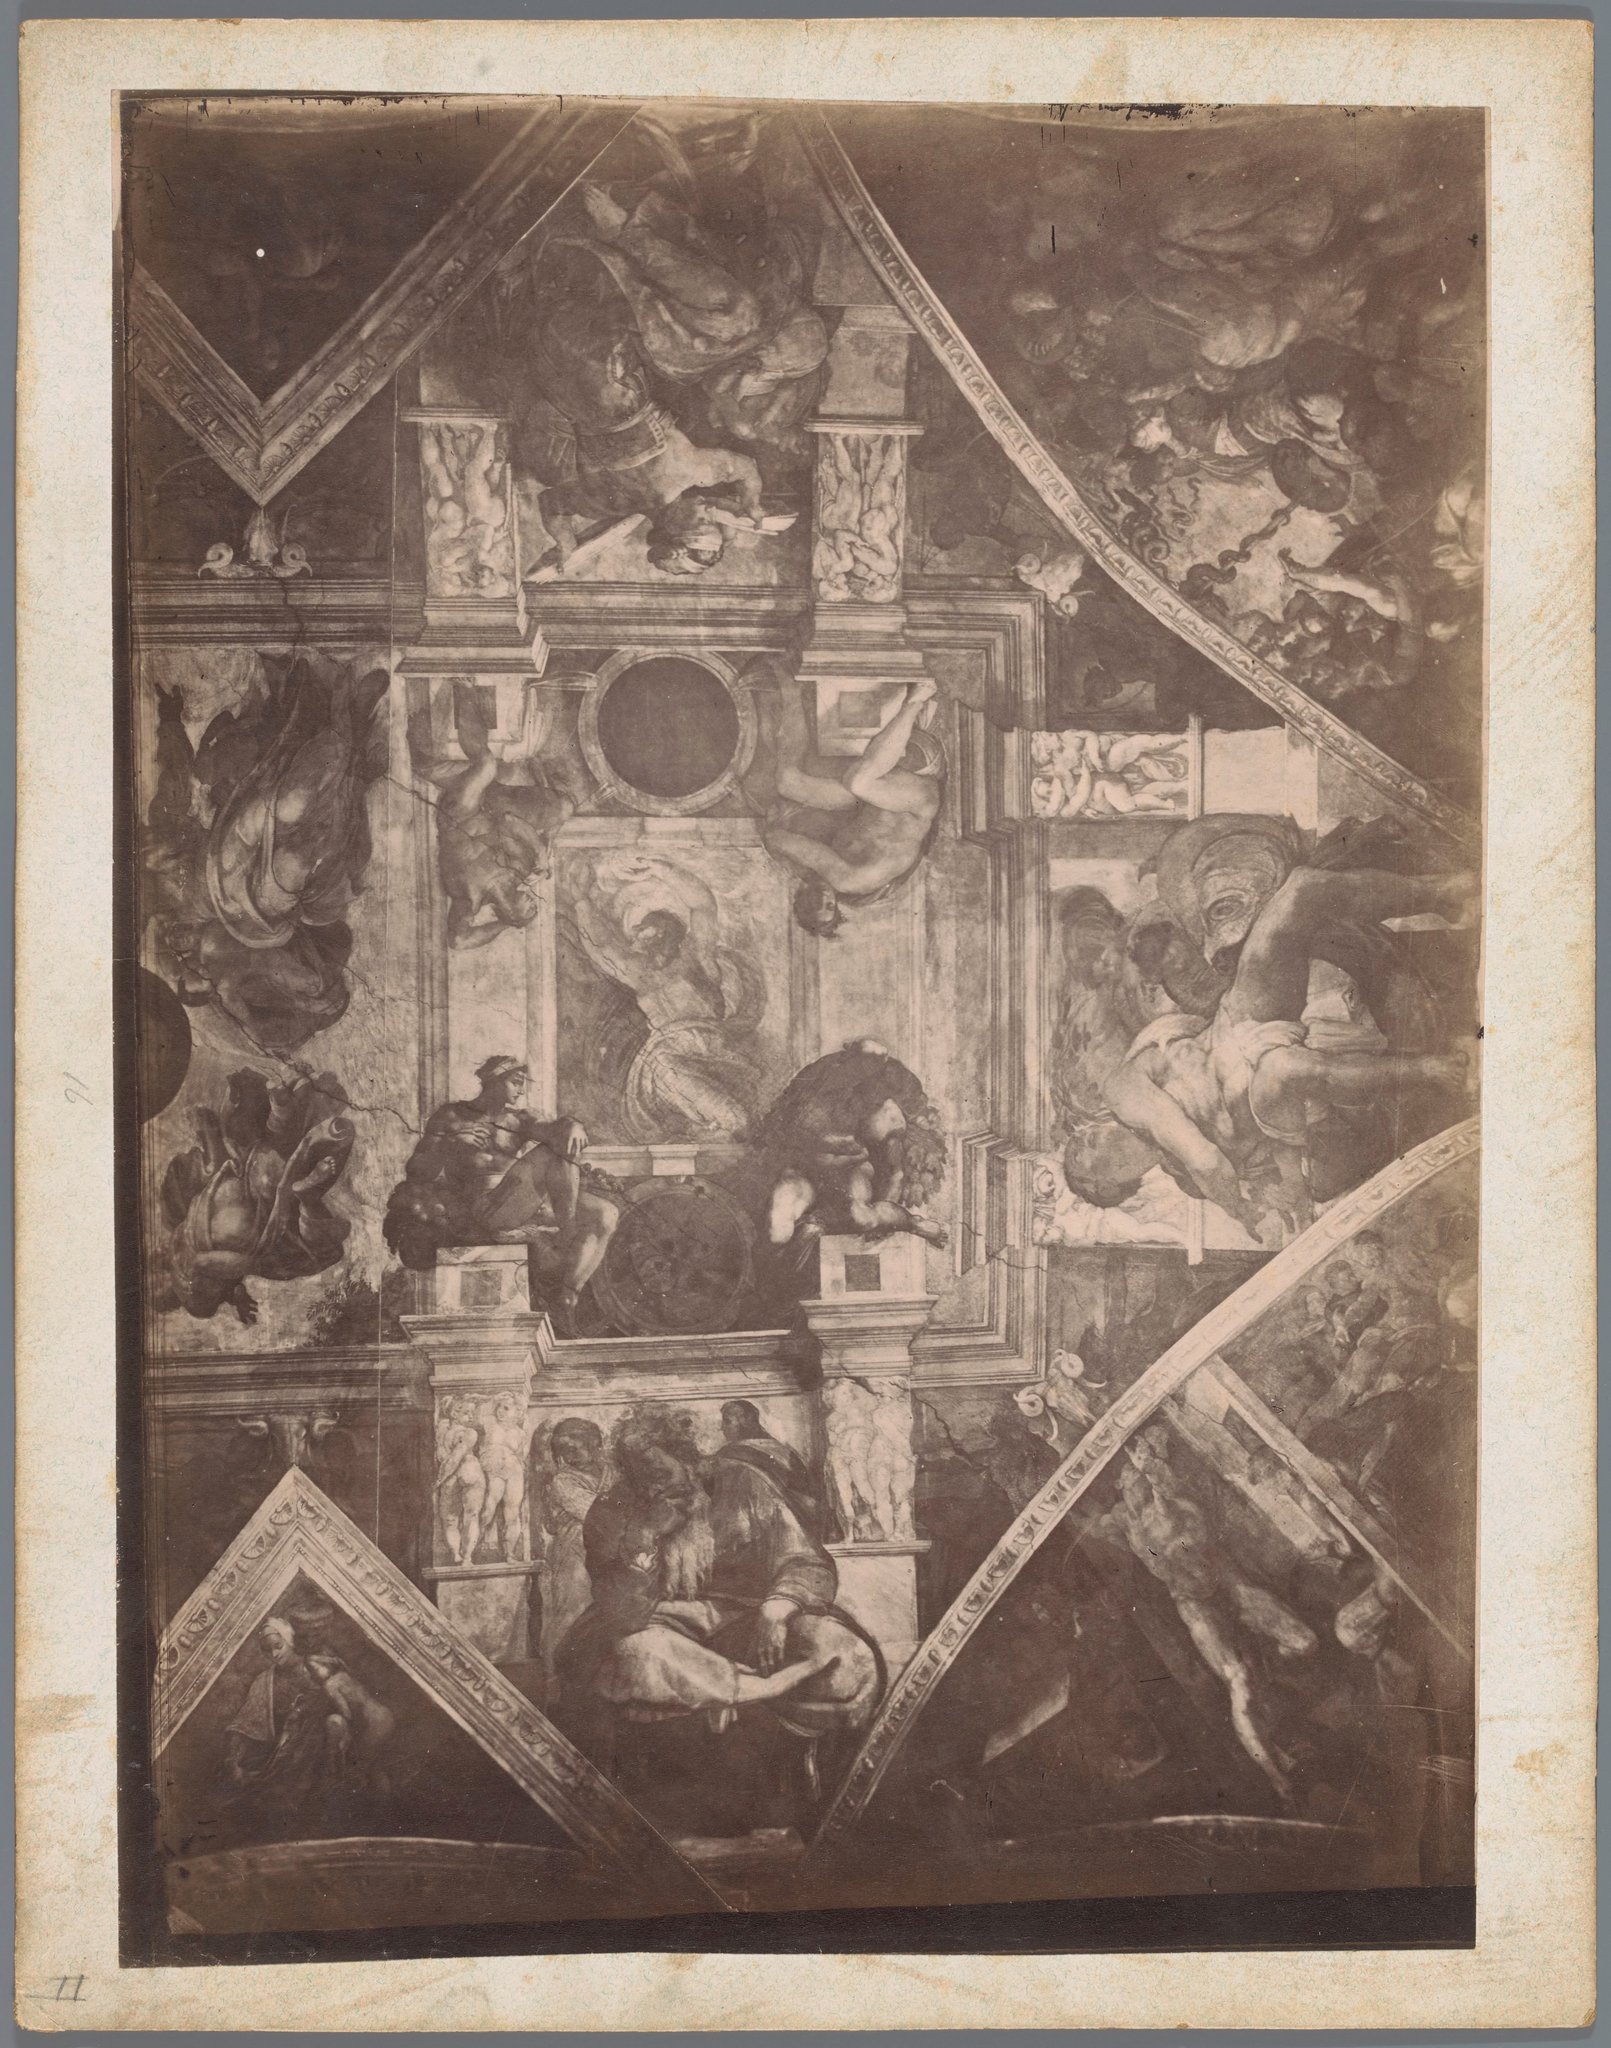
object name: photograph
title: Fotoreproductie van de fresco's op het plafond van de Sixtijnse Kapel door Michelangelo, voorstellende het scheiden van licht en duisternis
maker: Anonymous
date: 1875-1900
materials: cardboard, photographic support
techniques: albumen print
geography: vatican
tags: sitting figure, division of light and darkness, sibyls, groups of prophets, usually holding books or scrolls (isaiah, jeremiah, ezekiel, daniel, hosea, joel, amos, obadiah, jonah, micah, nahum, habakkuk, zephaniah, haggai, zechariah, malachi)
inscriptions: collector's mark: Lugt 3937